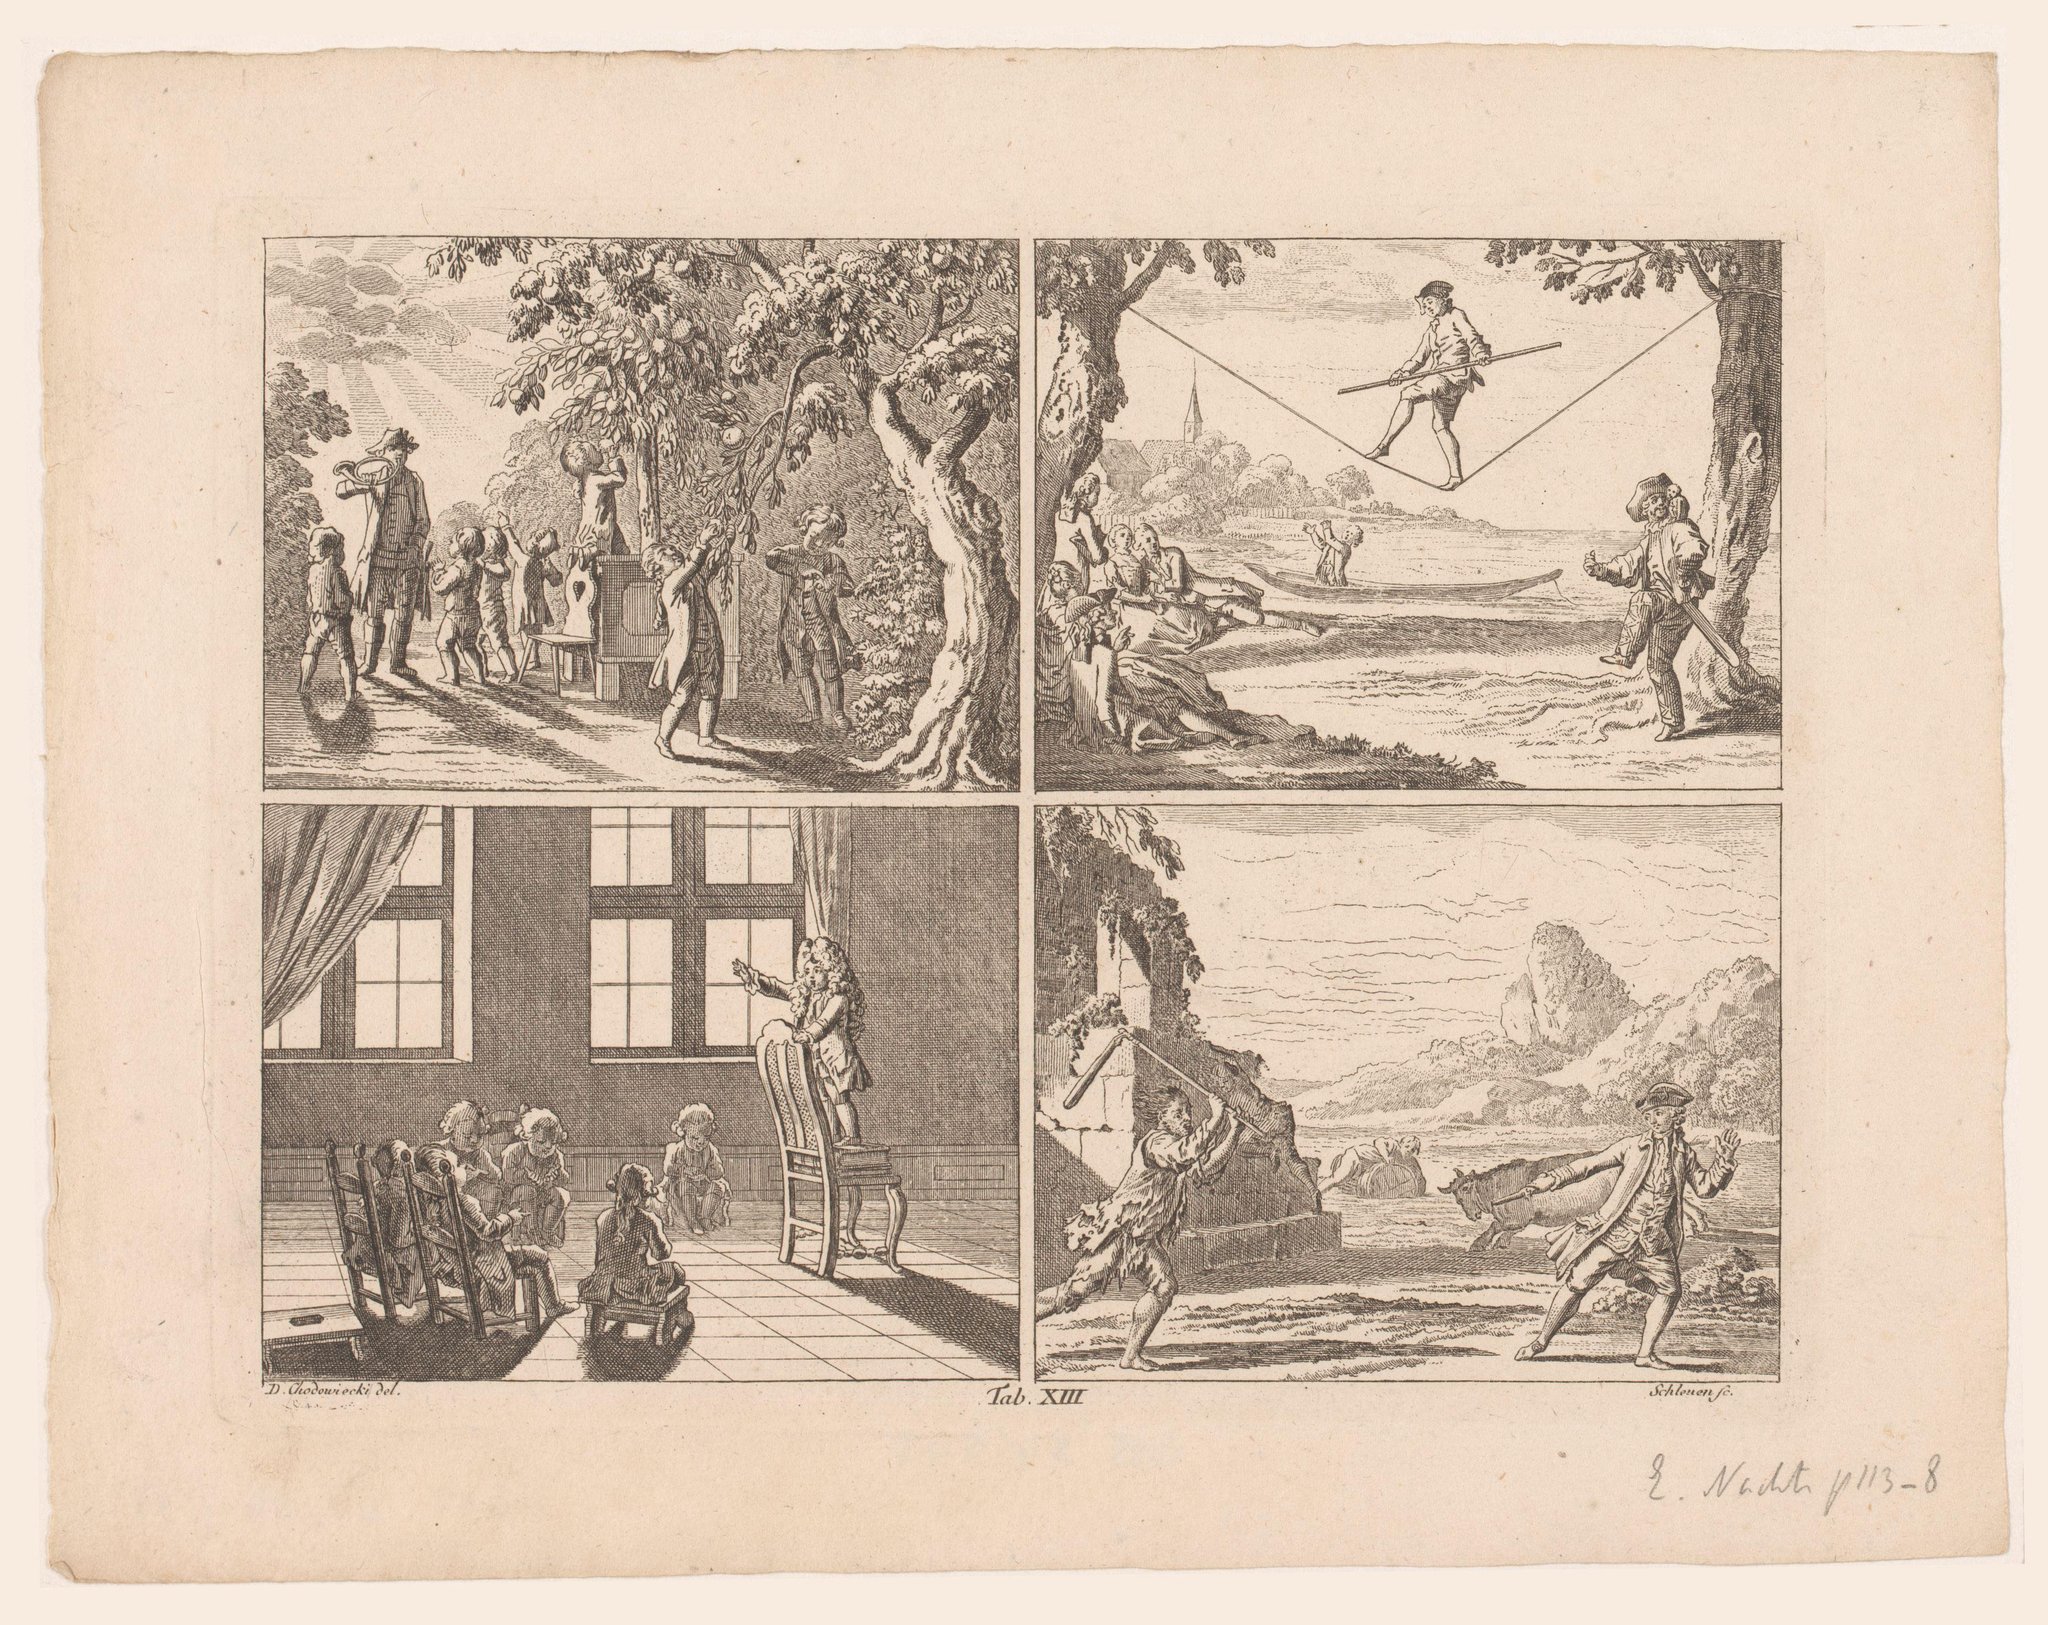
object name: print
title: Vier voorstellingen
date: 1765-1806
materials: paper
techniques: etching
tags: man and environment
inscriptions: collector's mark: Lugt 2228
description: Prent ook gebruikt in: Allgemeine deutsche Bibliothek. Berlijn en Stettin: Friedrich Nicolai, 1765-1806.